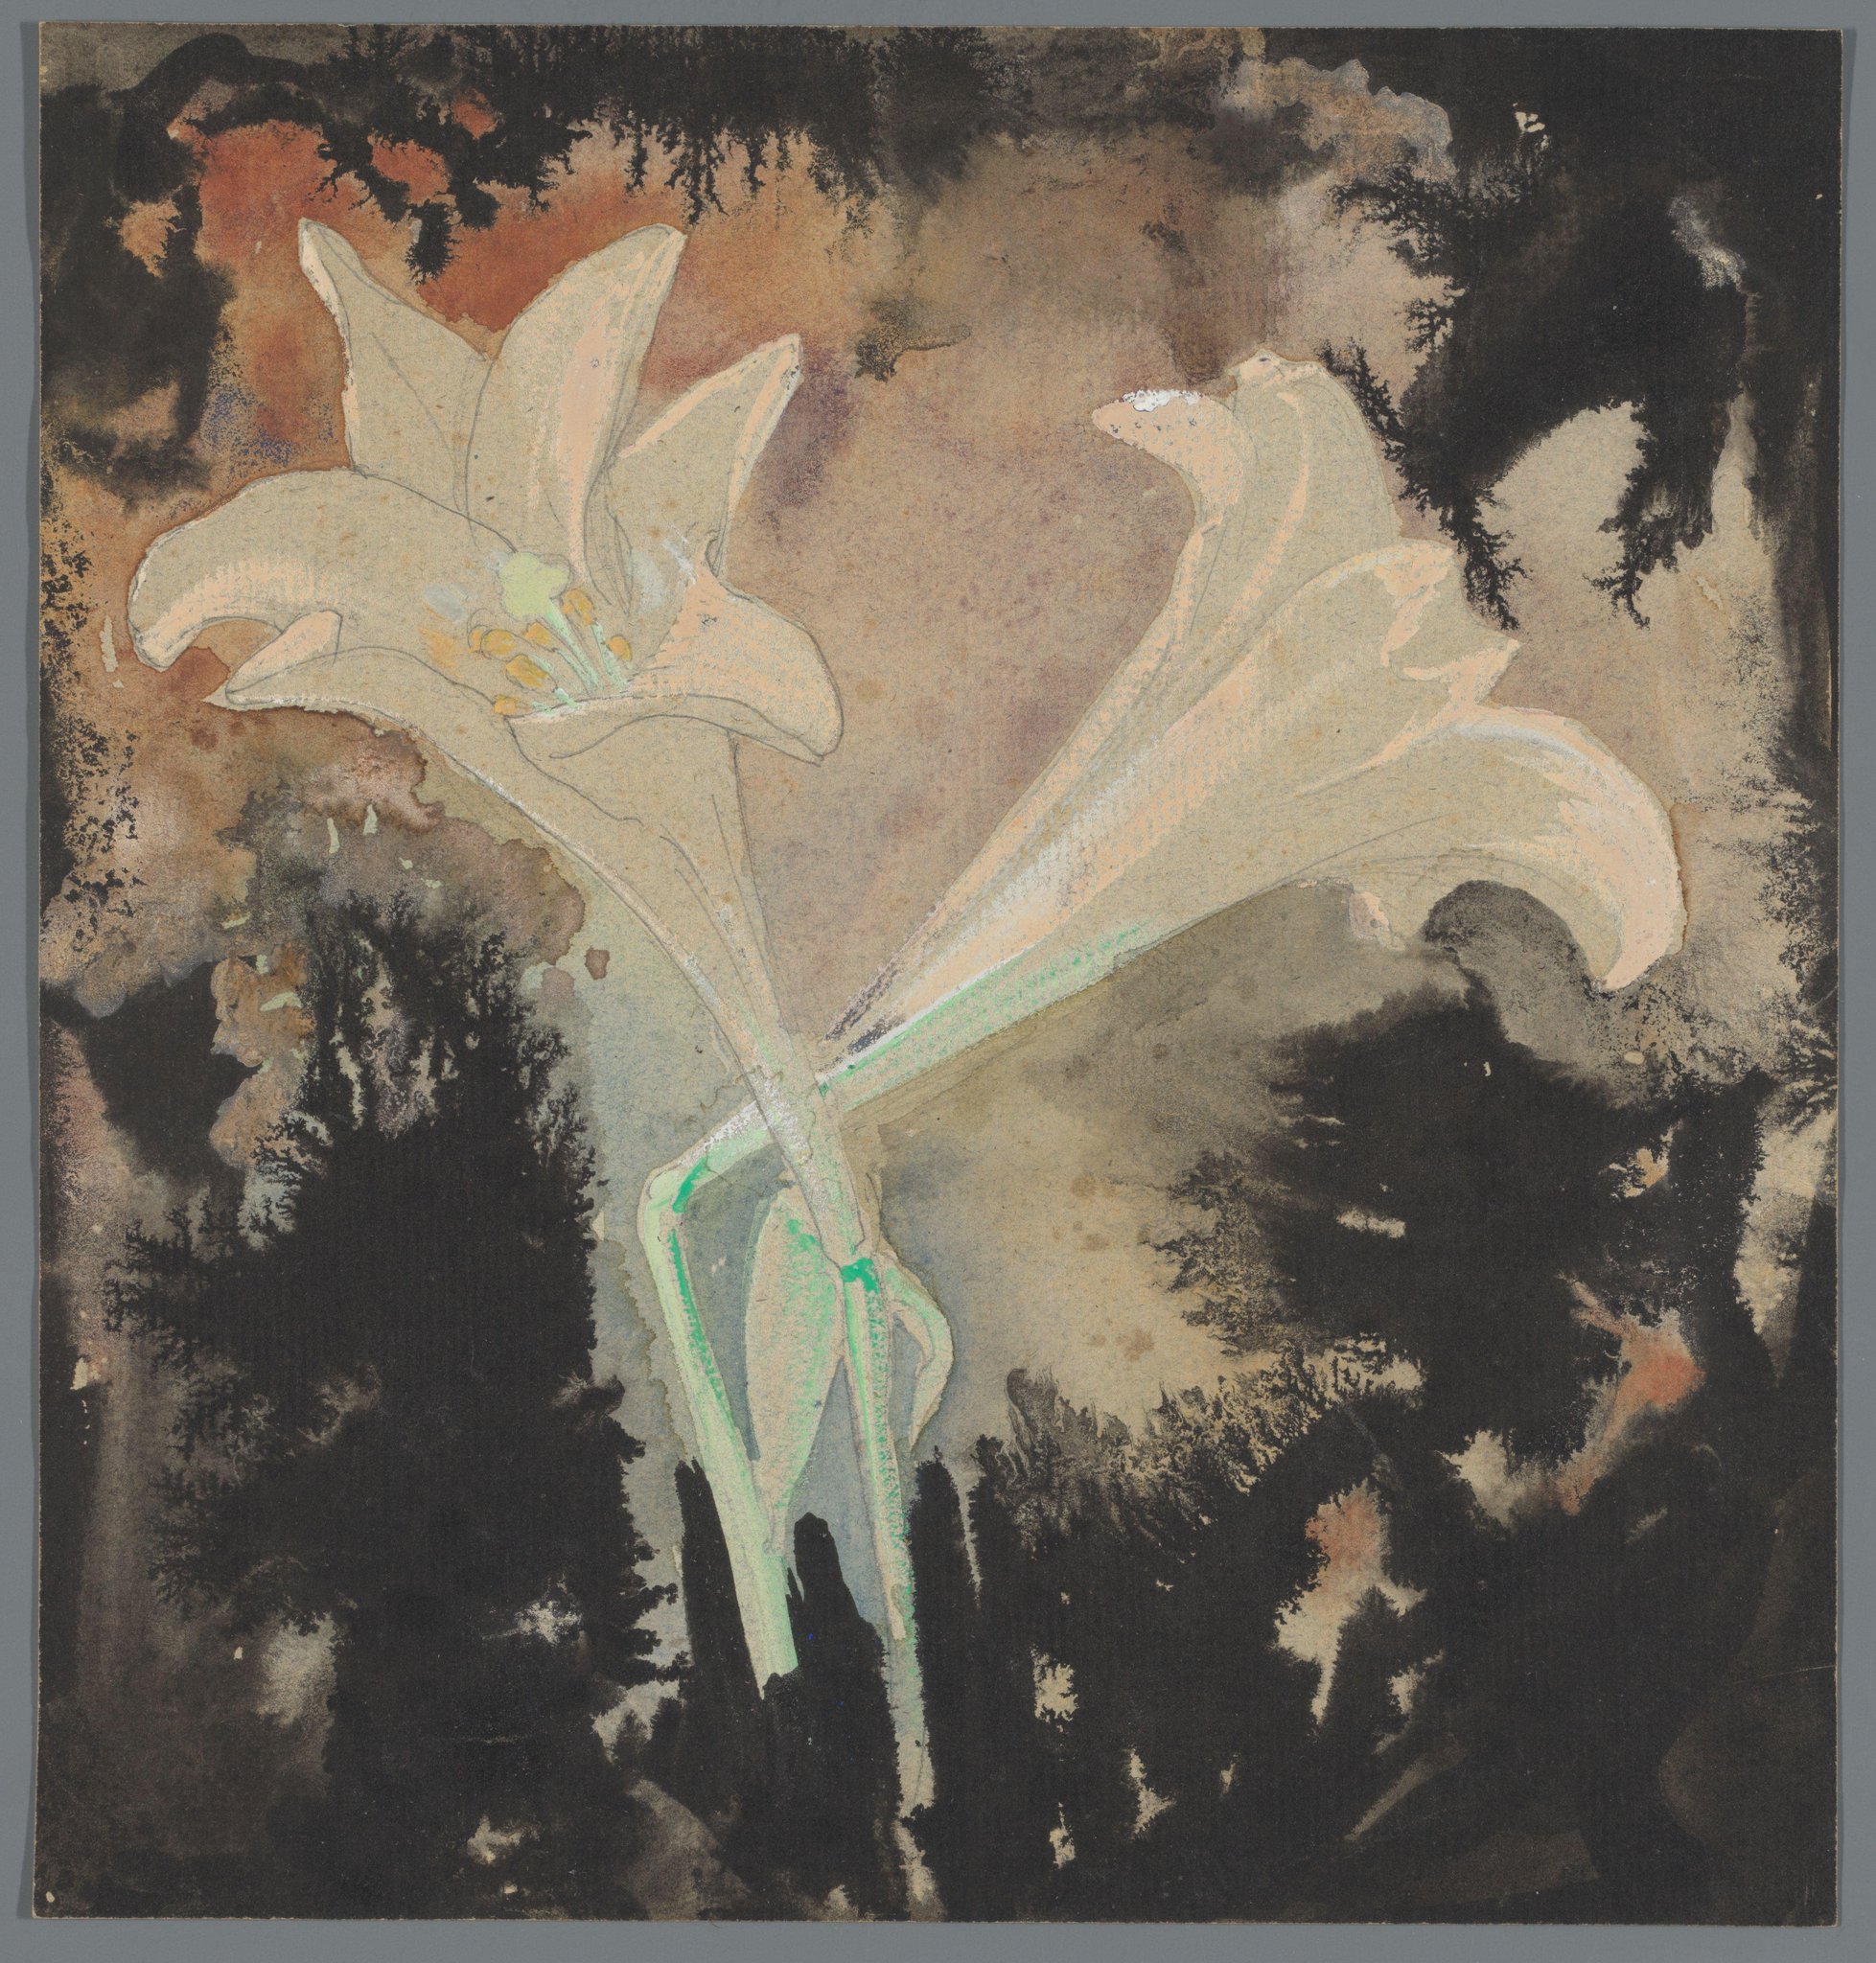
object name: drawing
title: Twee bloemen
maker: leo gestel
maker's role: draughtsman, print maker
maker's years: 1881-1941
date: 1902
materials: paint, ink, paper, pencil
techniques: brush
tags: flowers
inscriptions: annotation: ‘Jeugdwerk van Leo Gestel./ gemaakt in 1902. toen wij nog/ met Gerard van Vliet op de/ Rijks Normaalschool in Amsterdam/ waren./ Bergen Jan. 1942/ Jan Ponstijn’